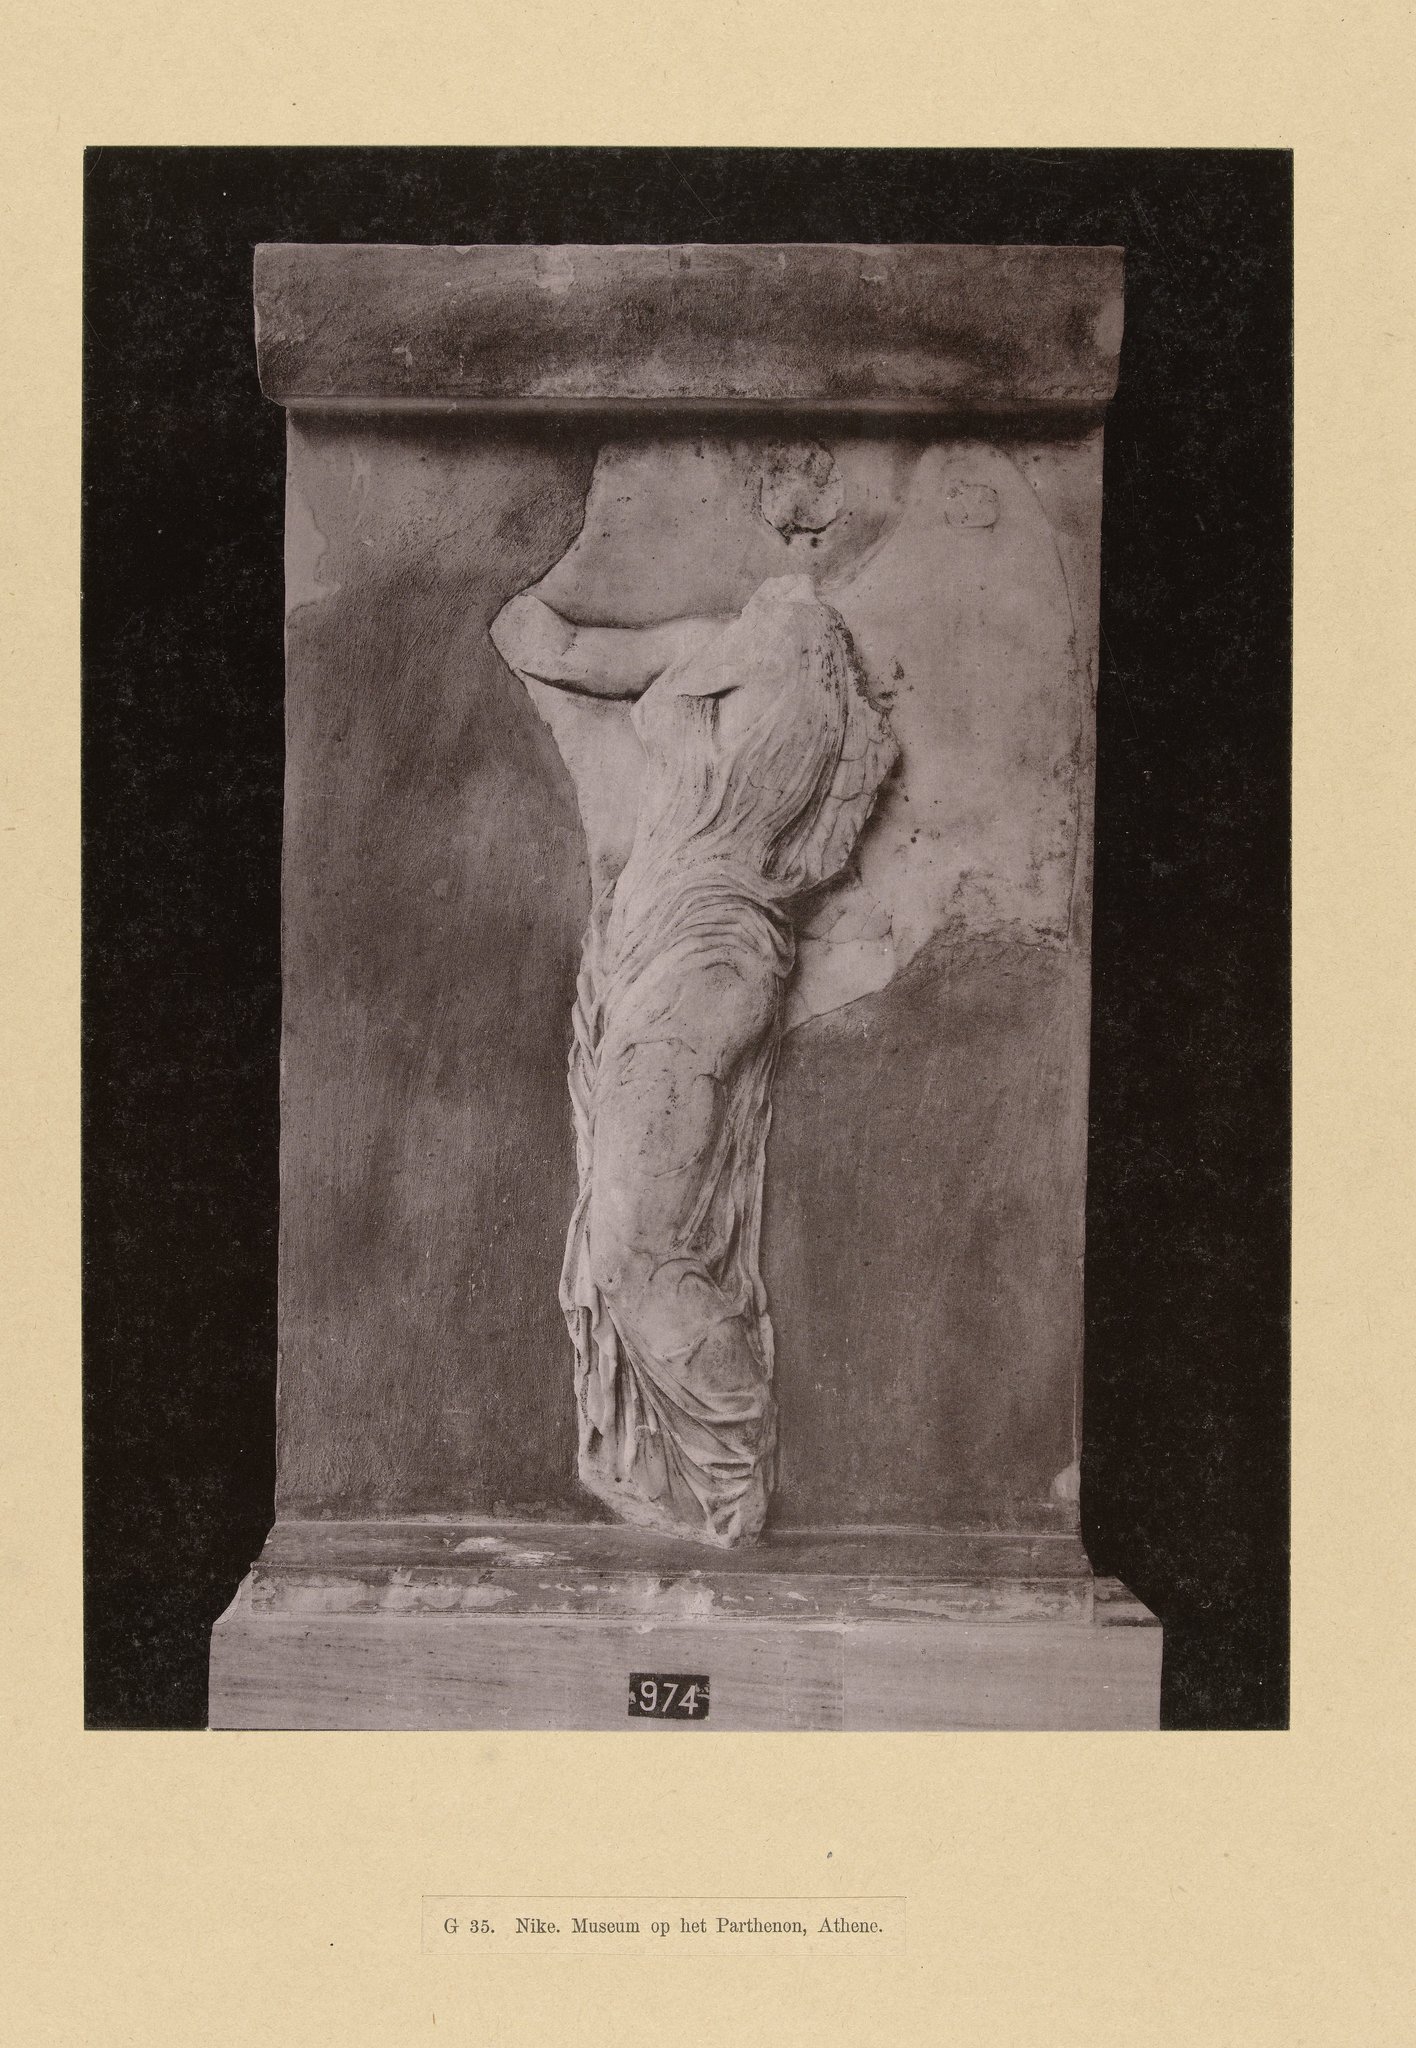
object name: photomechanical print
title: G 35. Nike. Museum op het Parthenon, Athene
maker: Anonymous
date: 1890-1895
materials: cardboard, paper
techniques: photograph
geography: athens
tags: piece of sculpture, reproduction of a piece of sculpture, (story of) nike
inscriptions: title: ‘G 35. Nike. Museum op het Parthenon, Athene.’, stamp: ‘Gemeentelijke bibliotheek/ Rotterdam’, check stamp: ‘Bristol/ L.M.’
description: Onderdeel van een groep door fotograaf Richard Polak op reis verzamelde foto’s. Deze fotomechanische afdruk is samen met andere op zijn reizen verzamelde foto's tentoongesteld bij de Rotterdamsche Kunstkring (1895), Arti en Amicitiae te Amsterdam (1897-1898?) en Societeit 't Collegie te Kampen (datum vooralsnog onbekend).